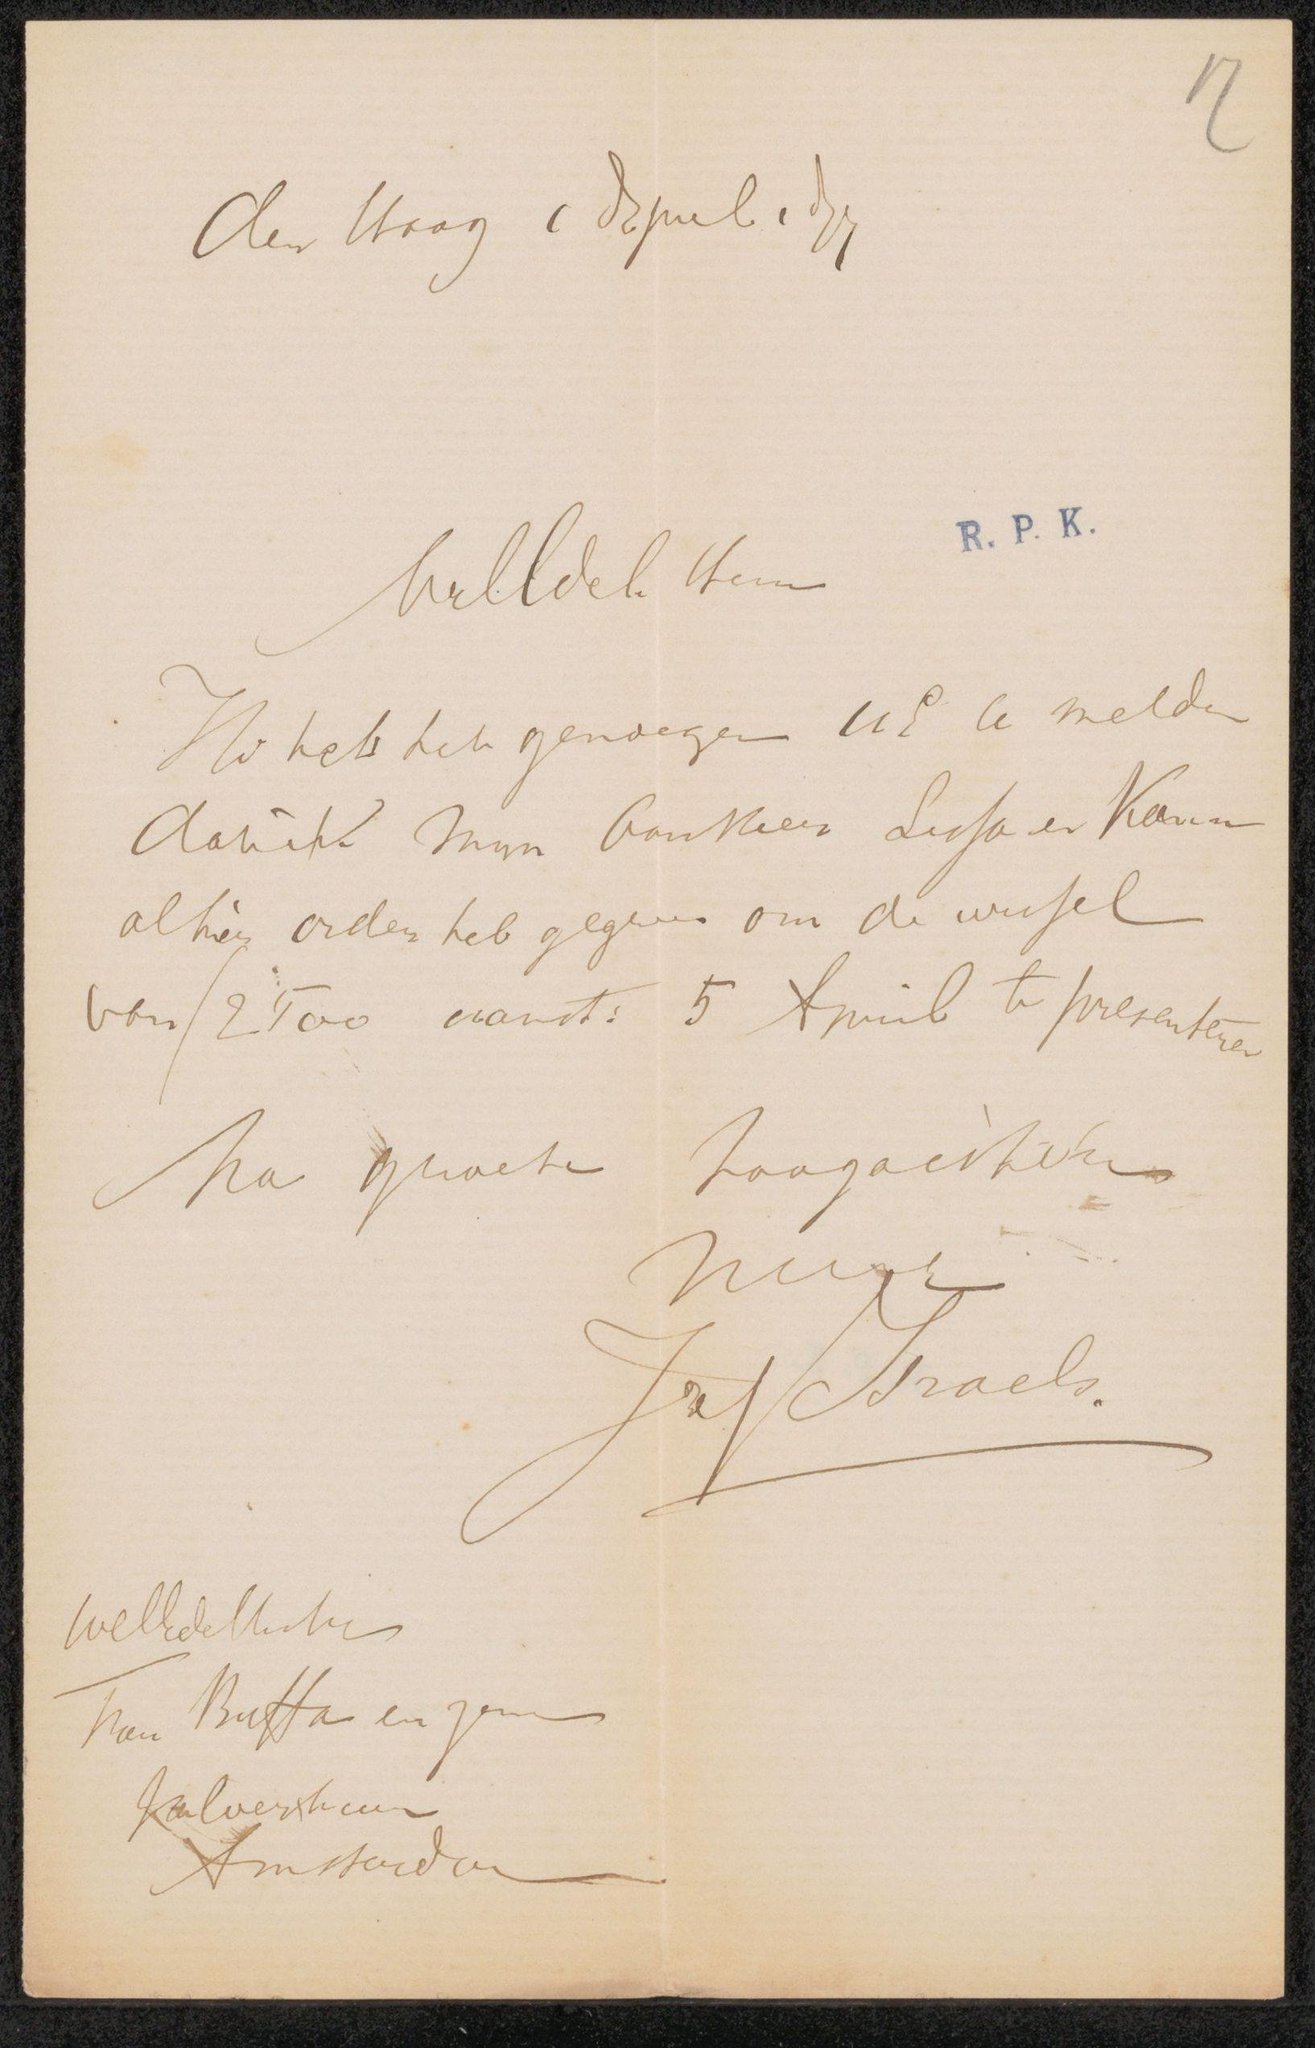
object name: letter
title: Brief aan Frans Buffa en Zonen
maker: jozef israëls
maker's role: draughtsman, painter, print maker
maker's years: 1824-1911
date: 1897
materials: ink, paper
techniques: pen, writing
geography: the hague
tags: money, amsterdam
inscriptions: collector's mark: Lugt 2233